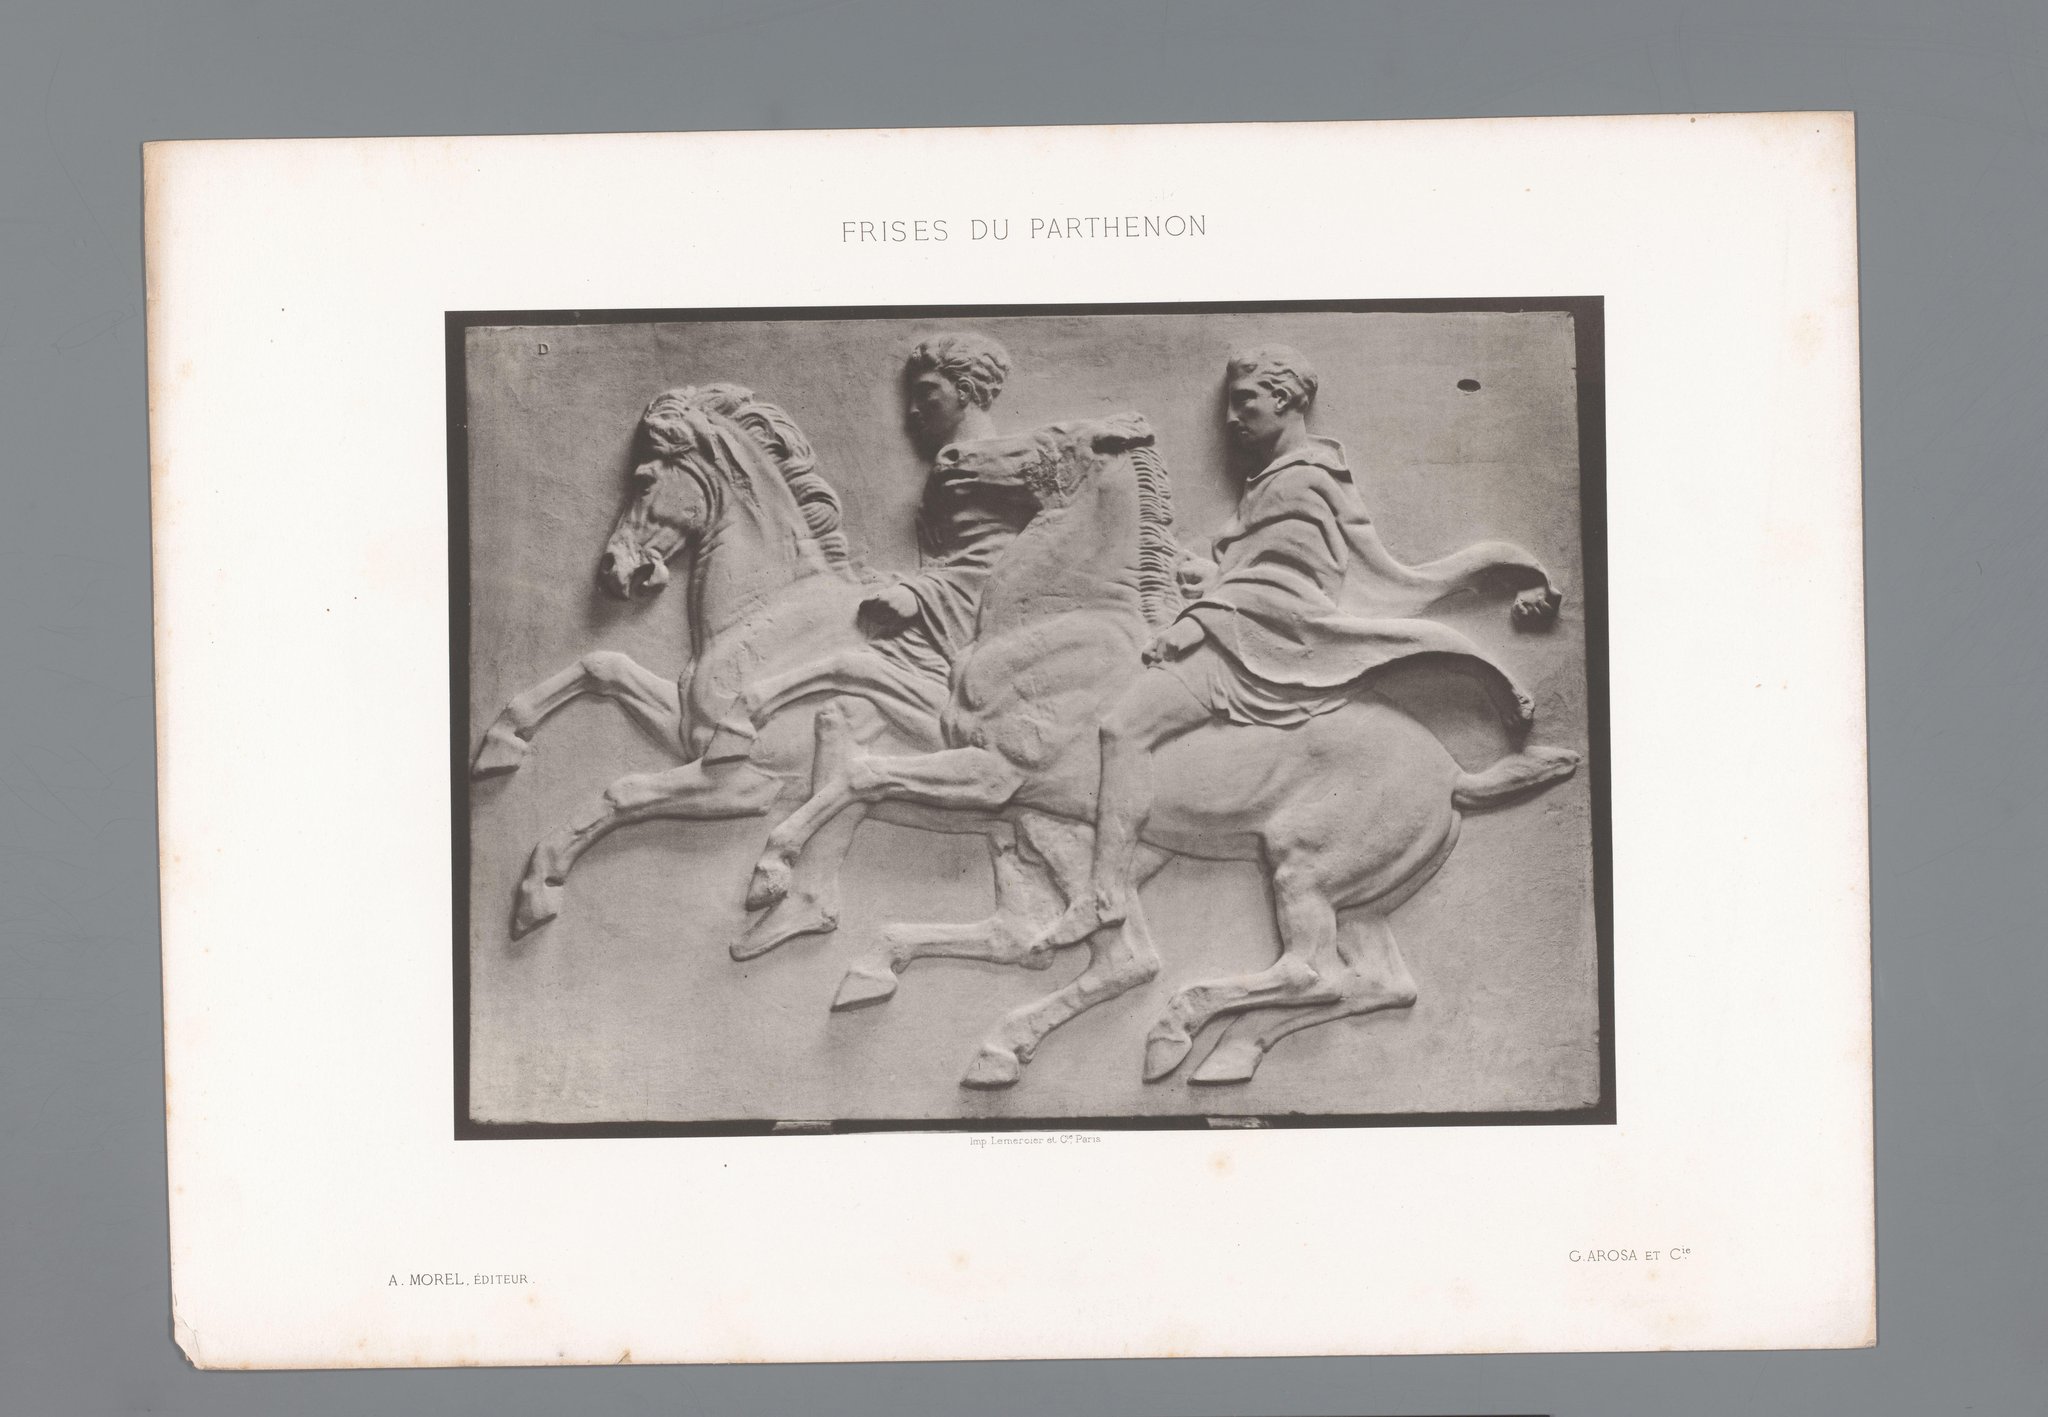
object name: photomechanical print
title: Deel van het fries van het Parthenon in Athene, afgebeeld twee ruiters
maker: a. morel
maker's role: publisher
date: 1863-1868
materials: paper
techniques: photograph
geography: paris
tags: riding a horse, ass, or mule; rider, horseman (+ two persons ~ traffic and transport), mouldings ~ architecture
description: Deze prent maakt deel uit van een omslag met 22 prenten en 3 tekstbladen.